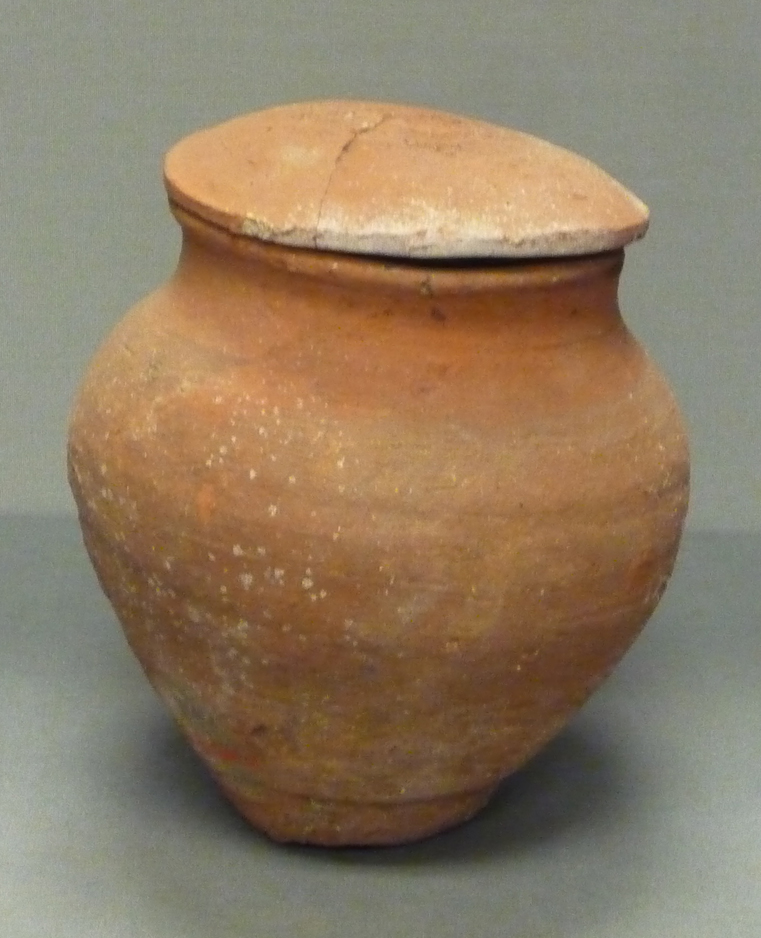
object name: jar with lid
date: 1479-1458 BCE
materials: pottery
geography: egypt